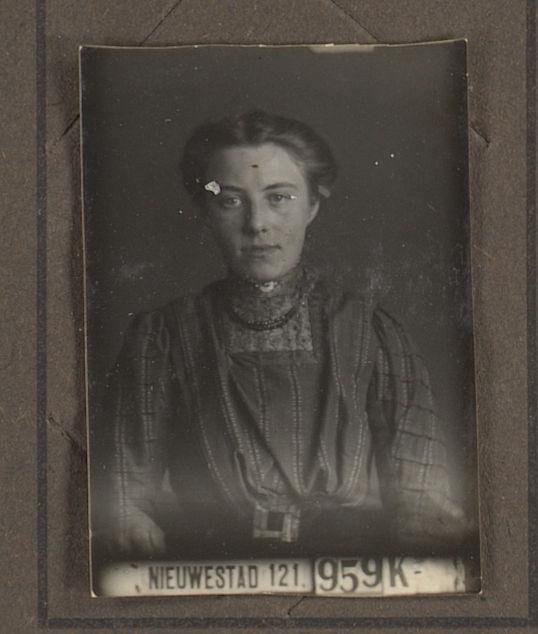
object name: album leaf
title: Portret van een onbekende jonge vrouw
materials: paper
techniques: gelatin silver print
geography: leeuwarden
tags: anonymous historical person portrayed - bb - woman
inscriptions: address: ‘NIEUWESTAD 121/ 960K’